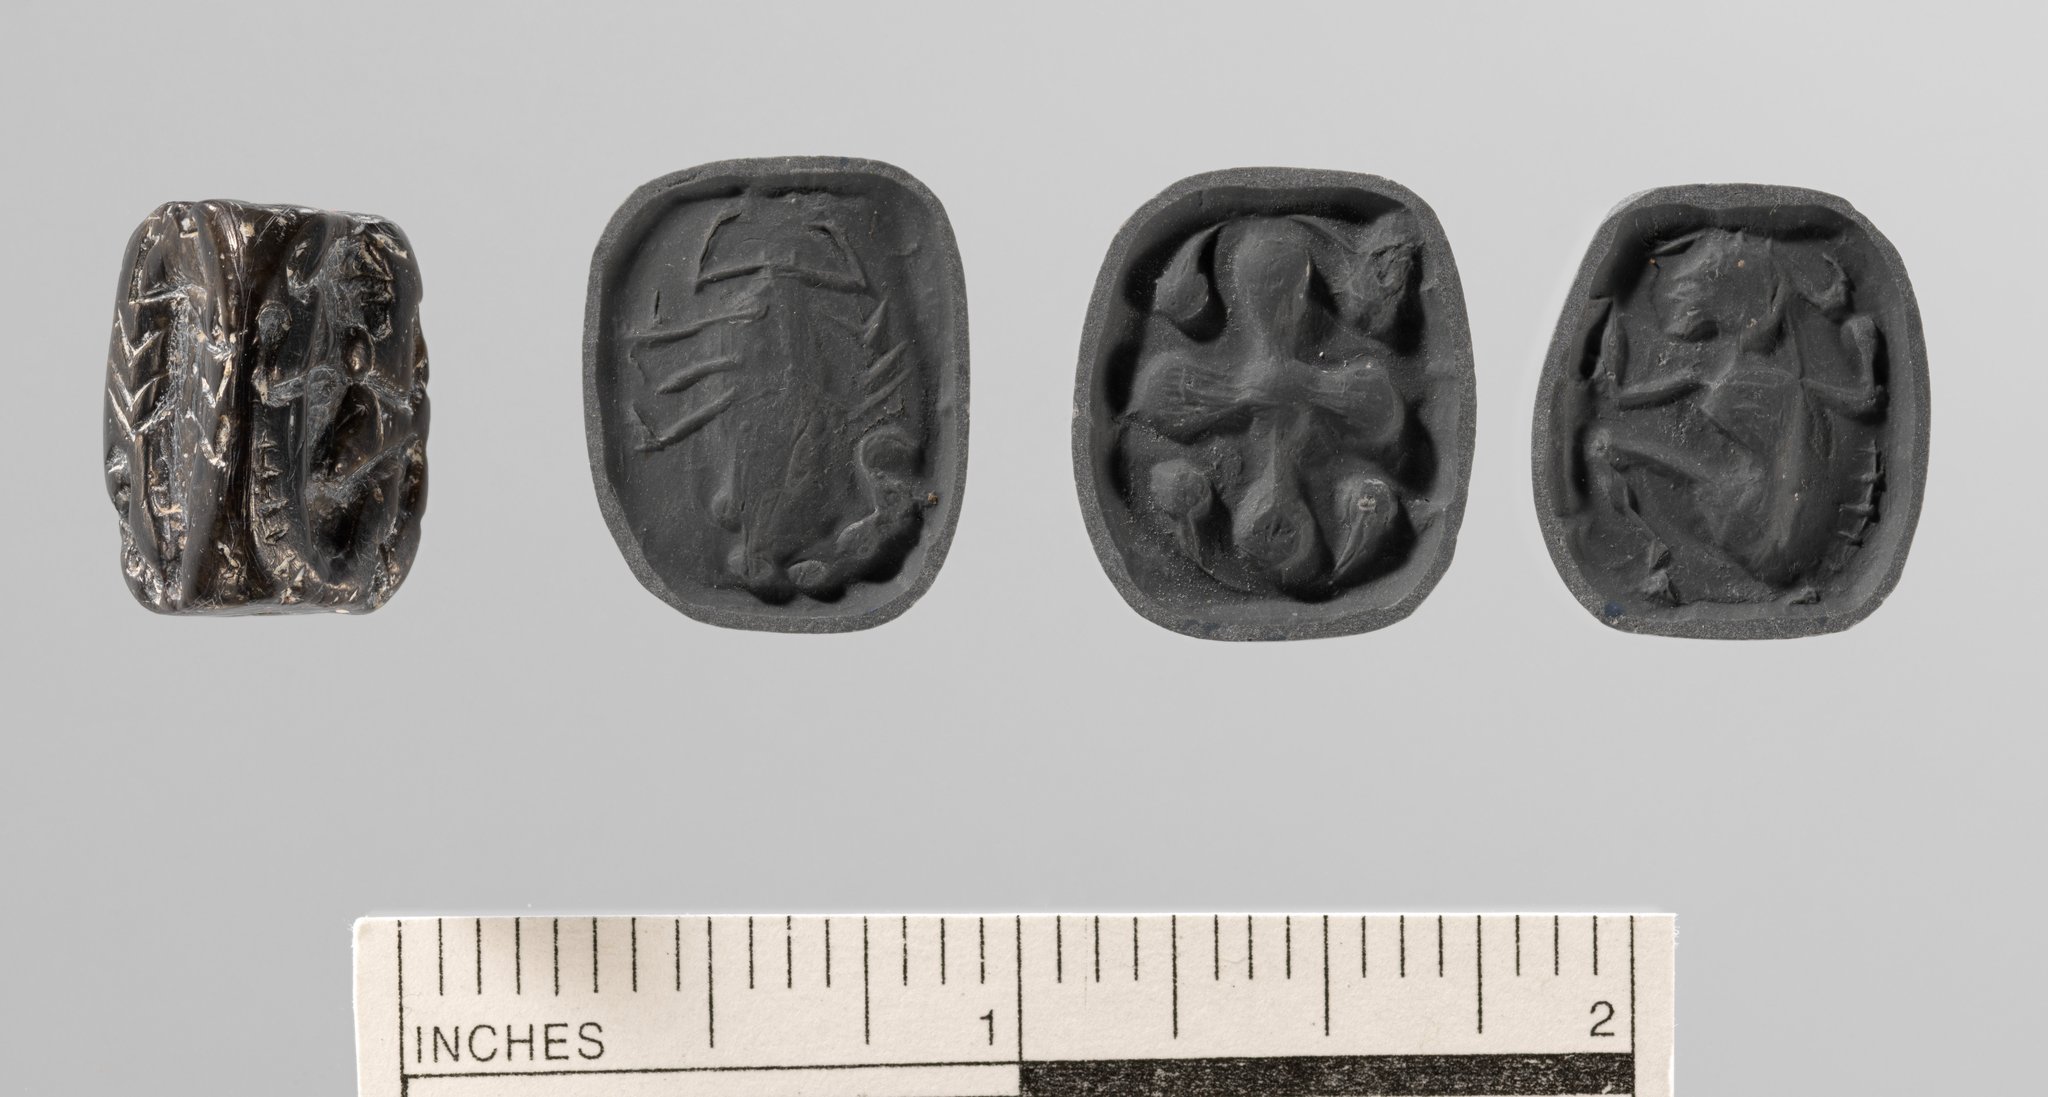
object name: prism, triangular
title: Steatite triangular prism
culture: minoan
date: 2200-1750 BCE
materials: stone